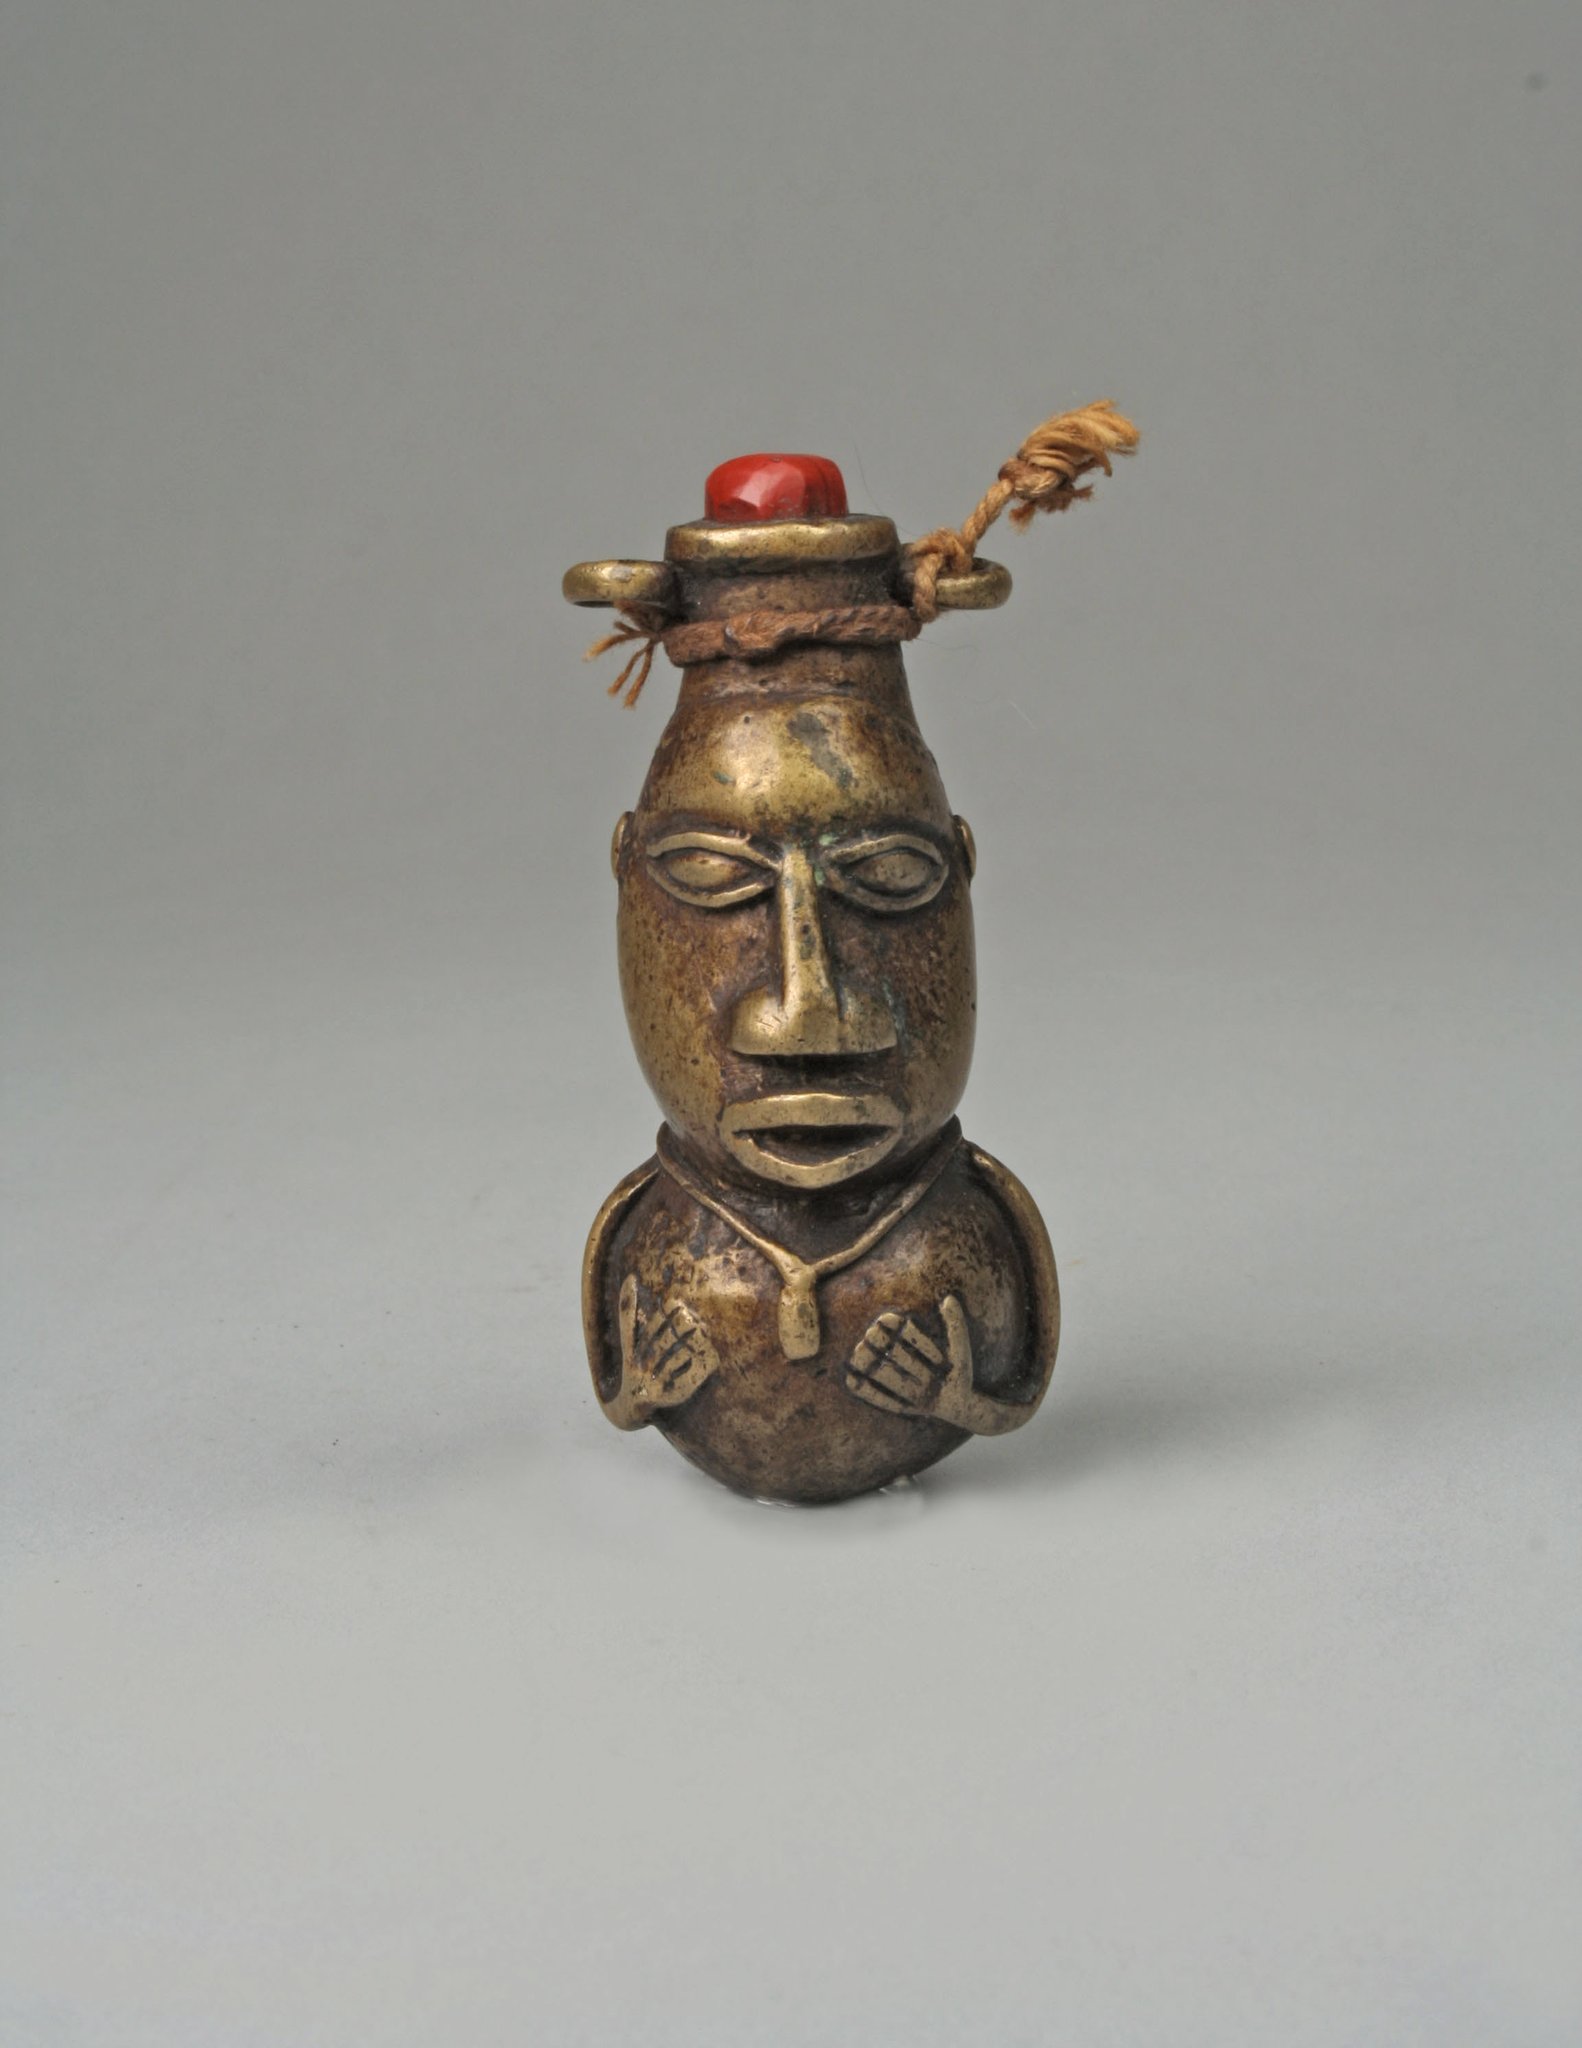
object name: vessel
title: Medicine Vessel: Figure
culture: edo period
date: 1701-1900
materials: brass, cord, stone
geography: nigeria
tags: faces